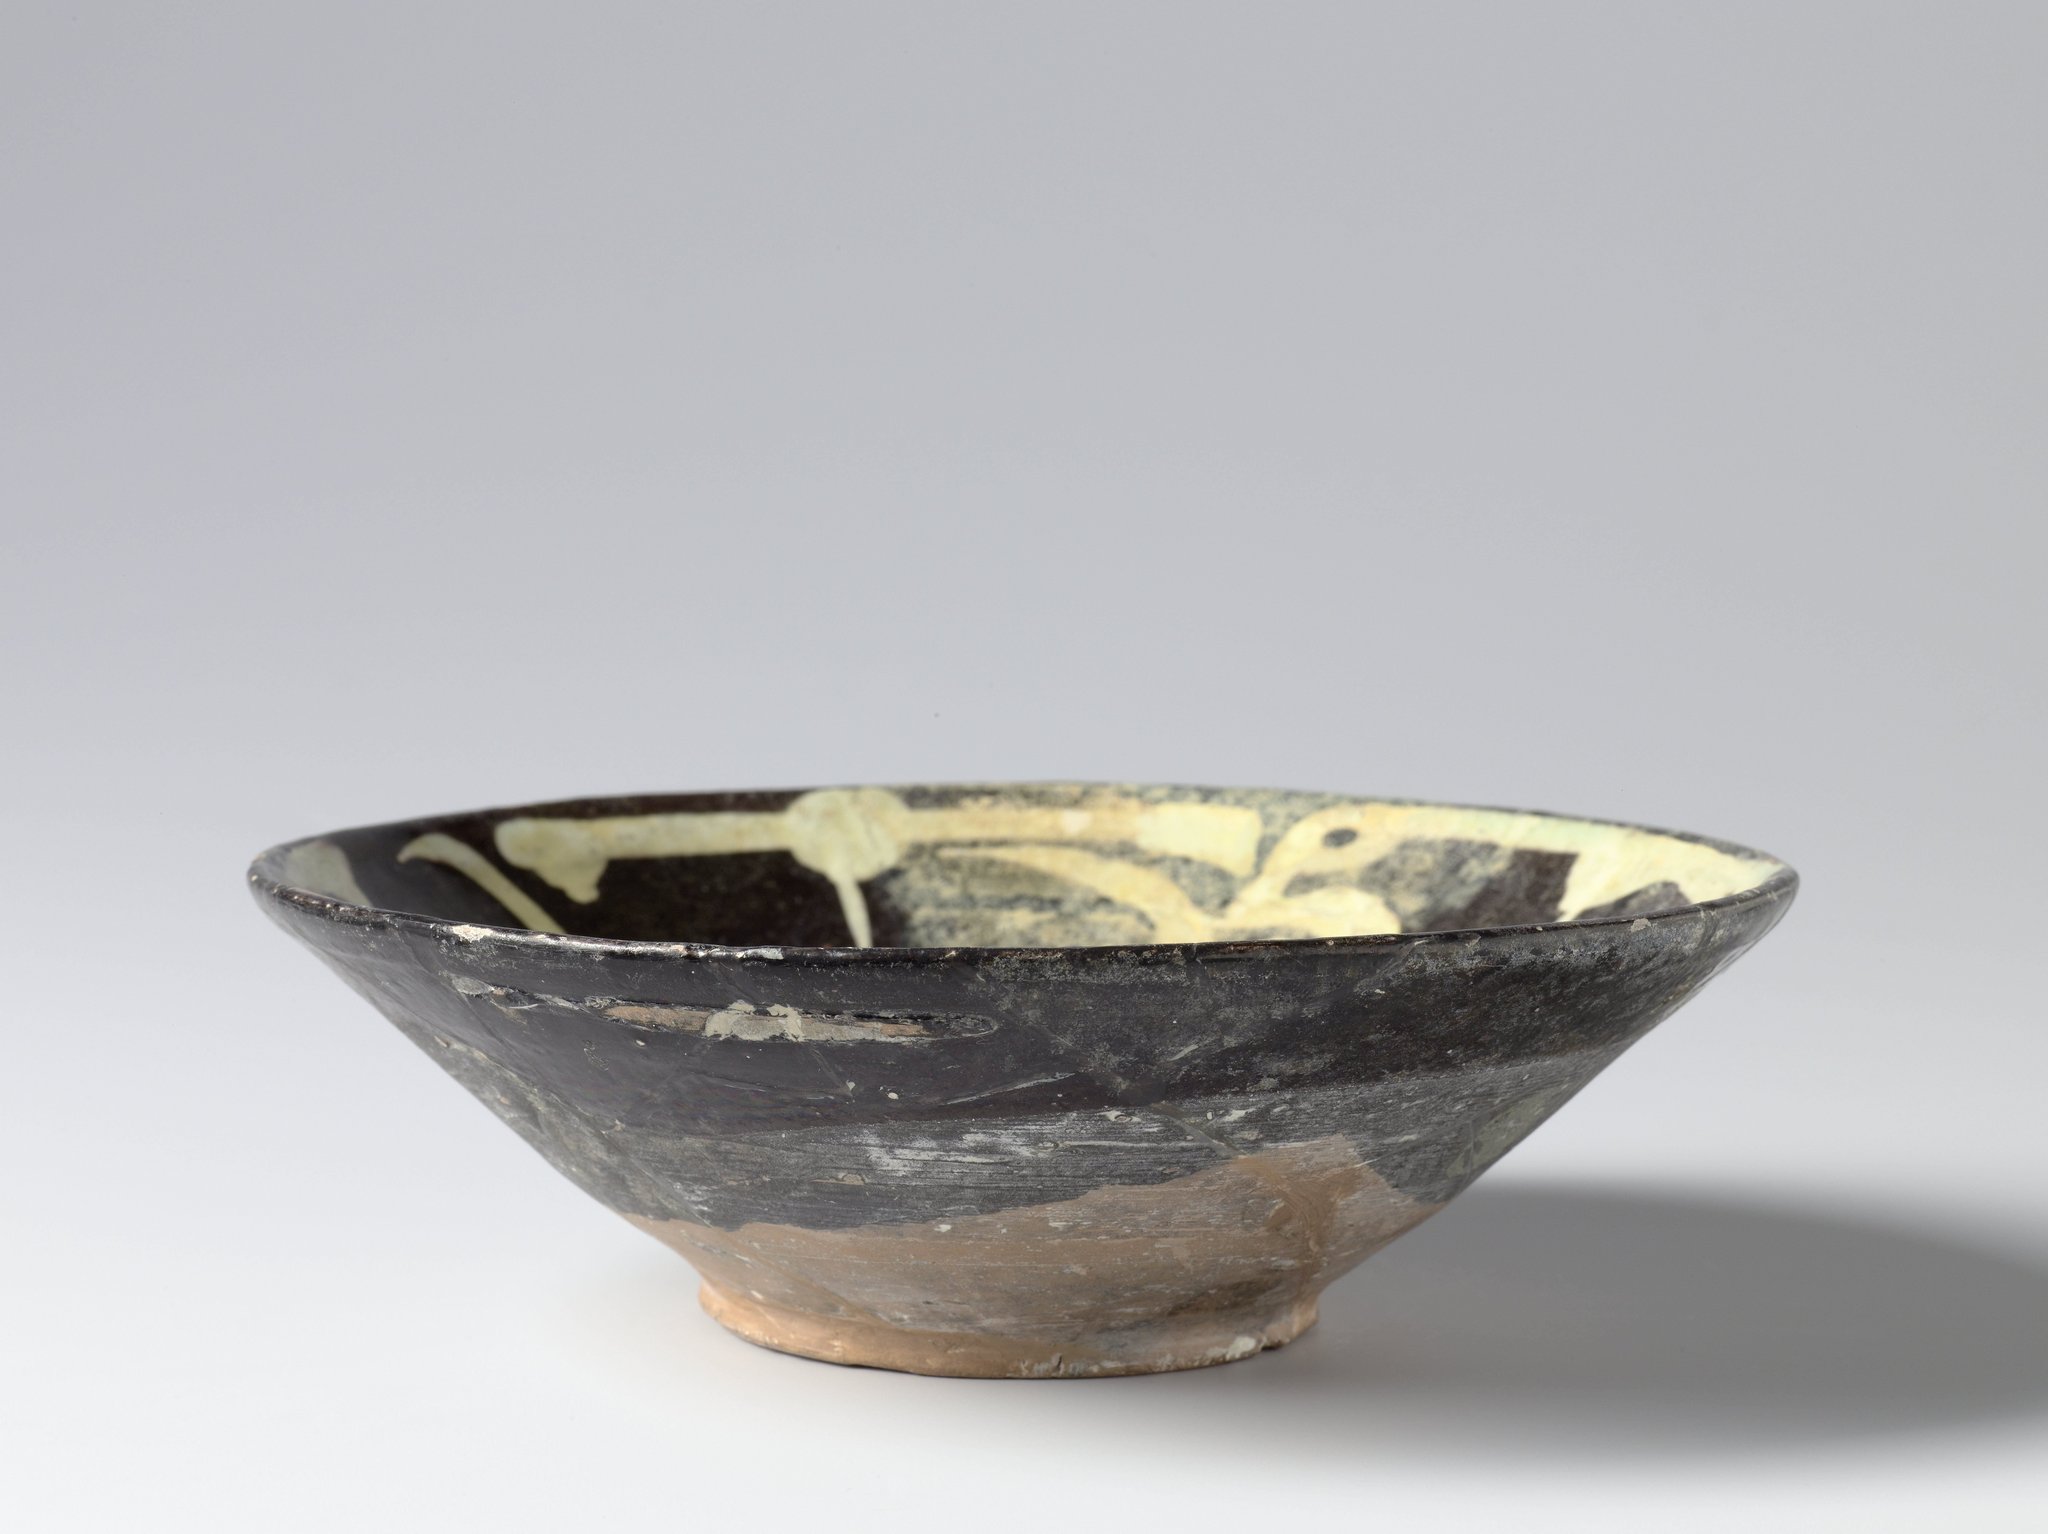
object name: bowl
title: Bowl with an (pseudo-)inscription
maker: Anonymous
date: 900-999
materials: earthenware, glaze, paint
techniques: firing, turning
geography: nishapur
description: Kom van aardewerk gedecoreerd in witte slib met (psuedo-)schrift op engobe van zwarte slib.